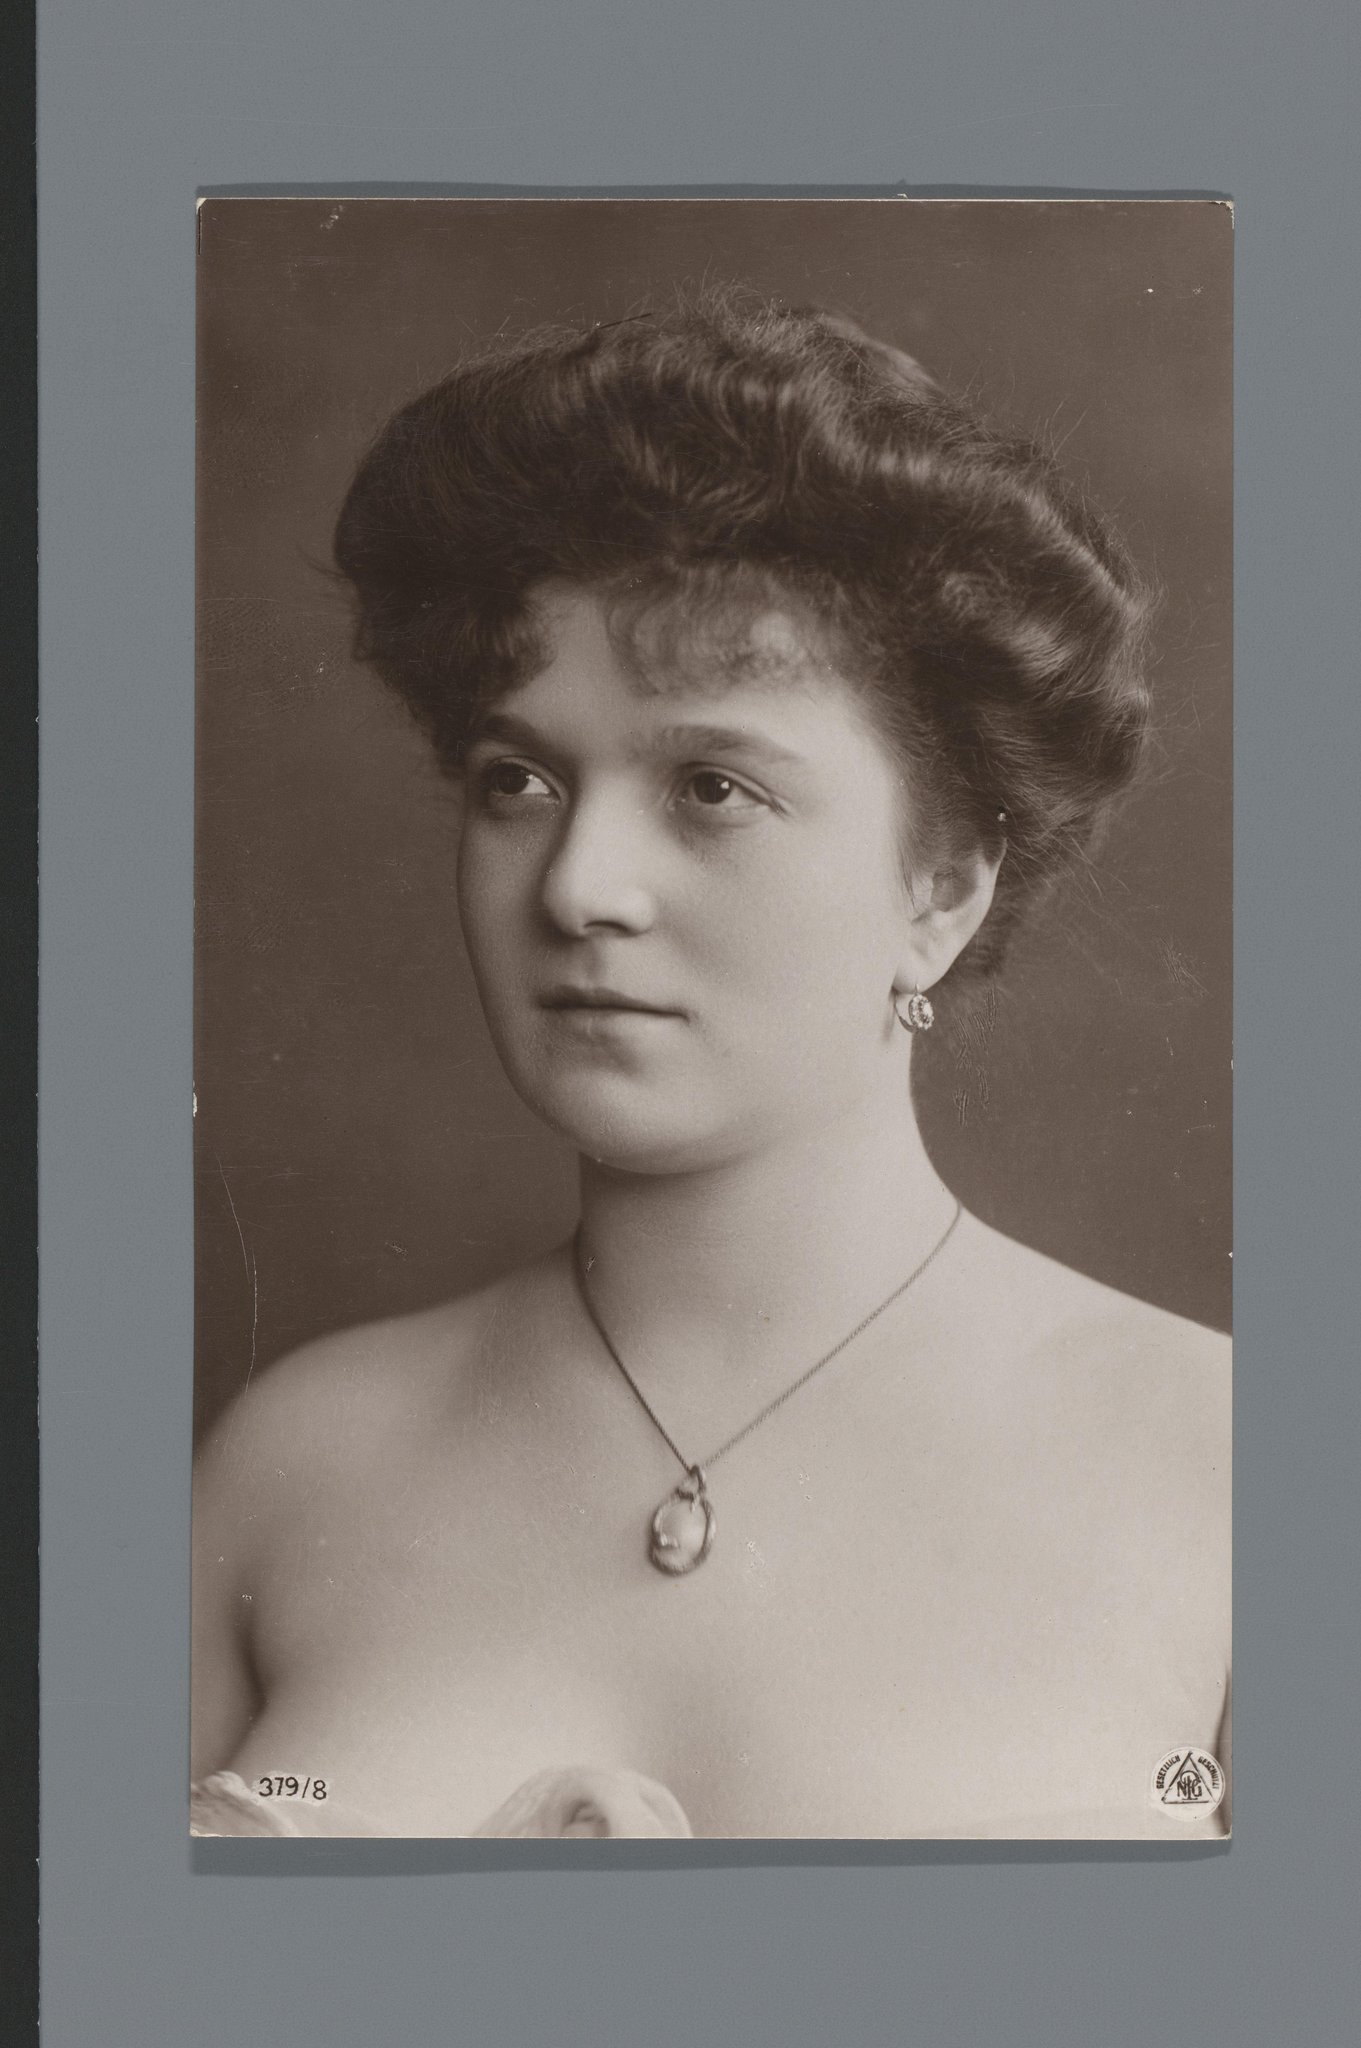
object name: photograph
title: Portret van een onbekende vrouw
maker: Anonymous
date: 1904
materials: photographic support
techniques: uranotype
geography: steglitz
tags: adult woman, anonymous historical person portrayed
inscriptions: inscription: ‘Oranotypie/ Neue Photographische Gesellschaft A.G., Steglitz. 1904./ Als Postkarte offe hinterlegt zum Musterschutz-Register/ beim Ambtsgericht Berlin.’